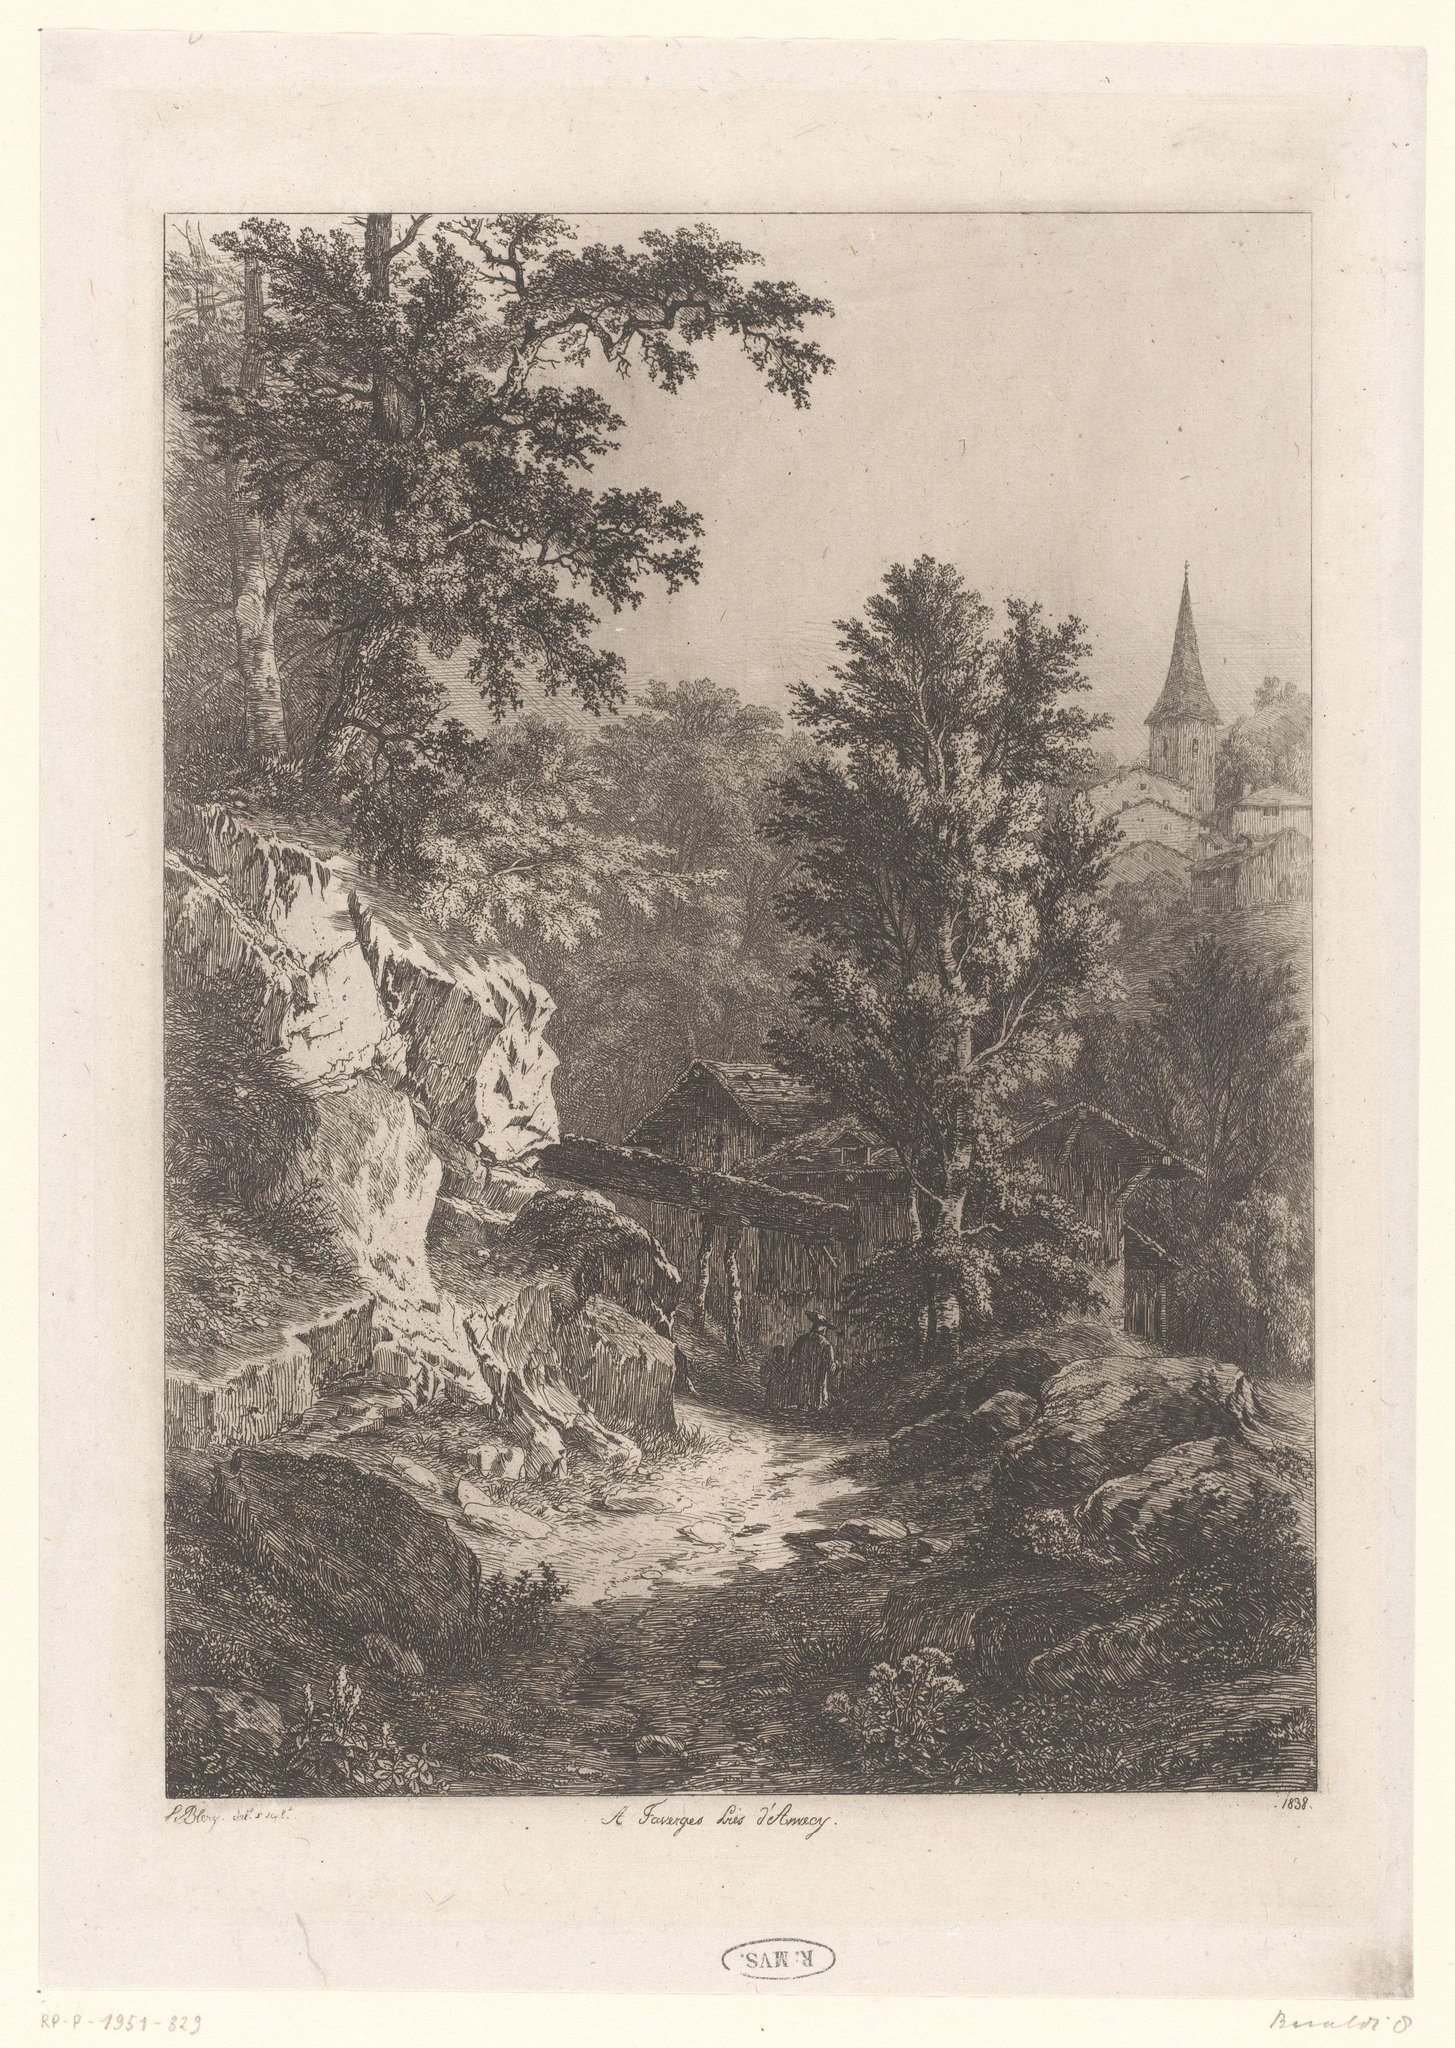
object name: print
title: A Faverges Près d'Annecy.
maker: eugène bléry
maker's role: print maker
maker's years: 1805-1887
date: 1838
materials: paper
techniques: engraving, etching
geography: fontainebleau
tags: rural housing, e.g. country-house, villa, cottage, church (exterior) - qq - small church, chapel, rocks - hh - ideal landscapes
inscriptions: collector's mark: Lugt 2228